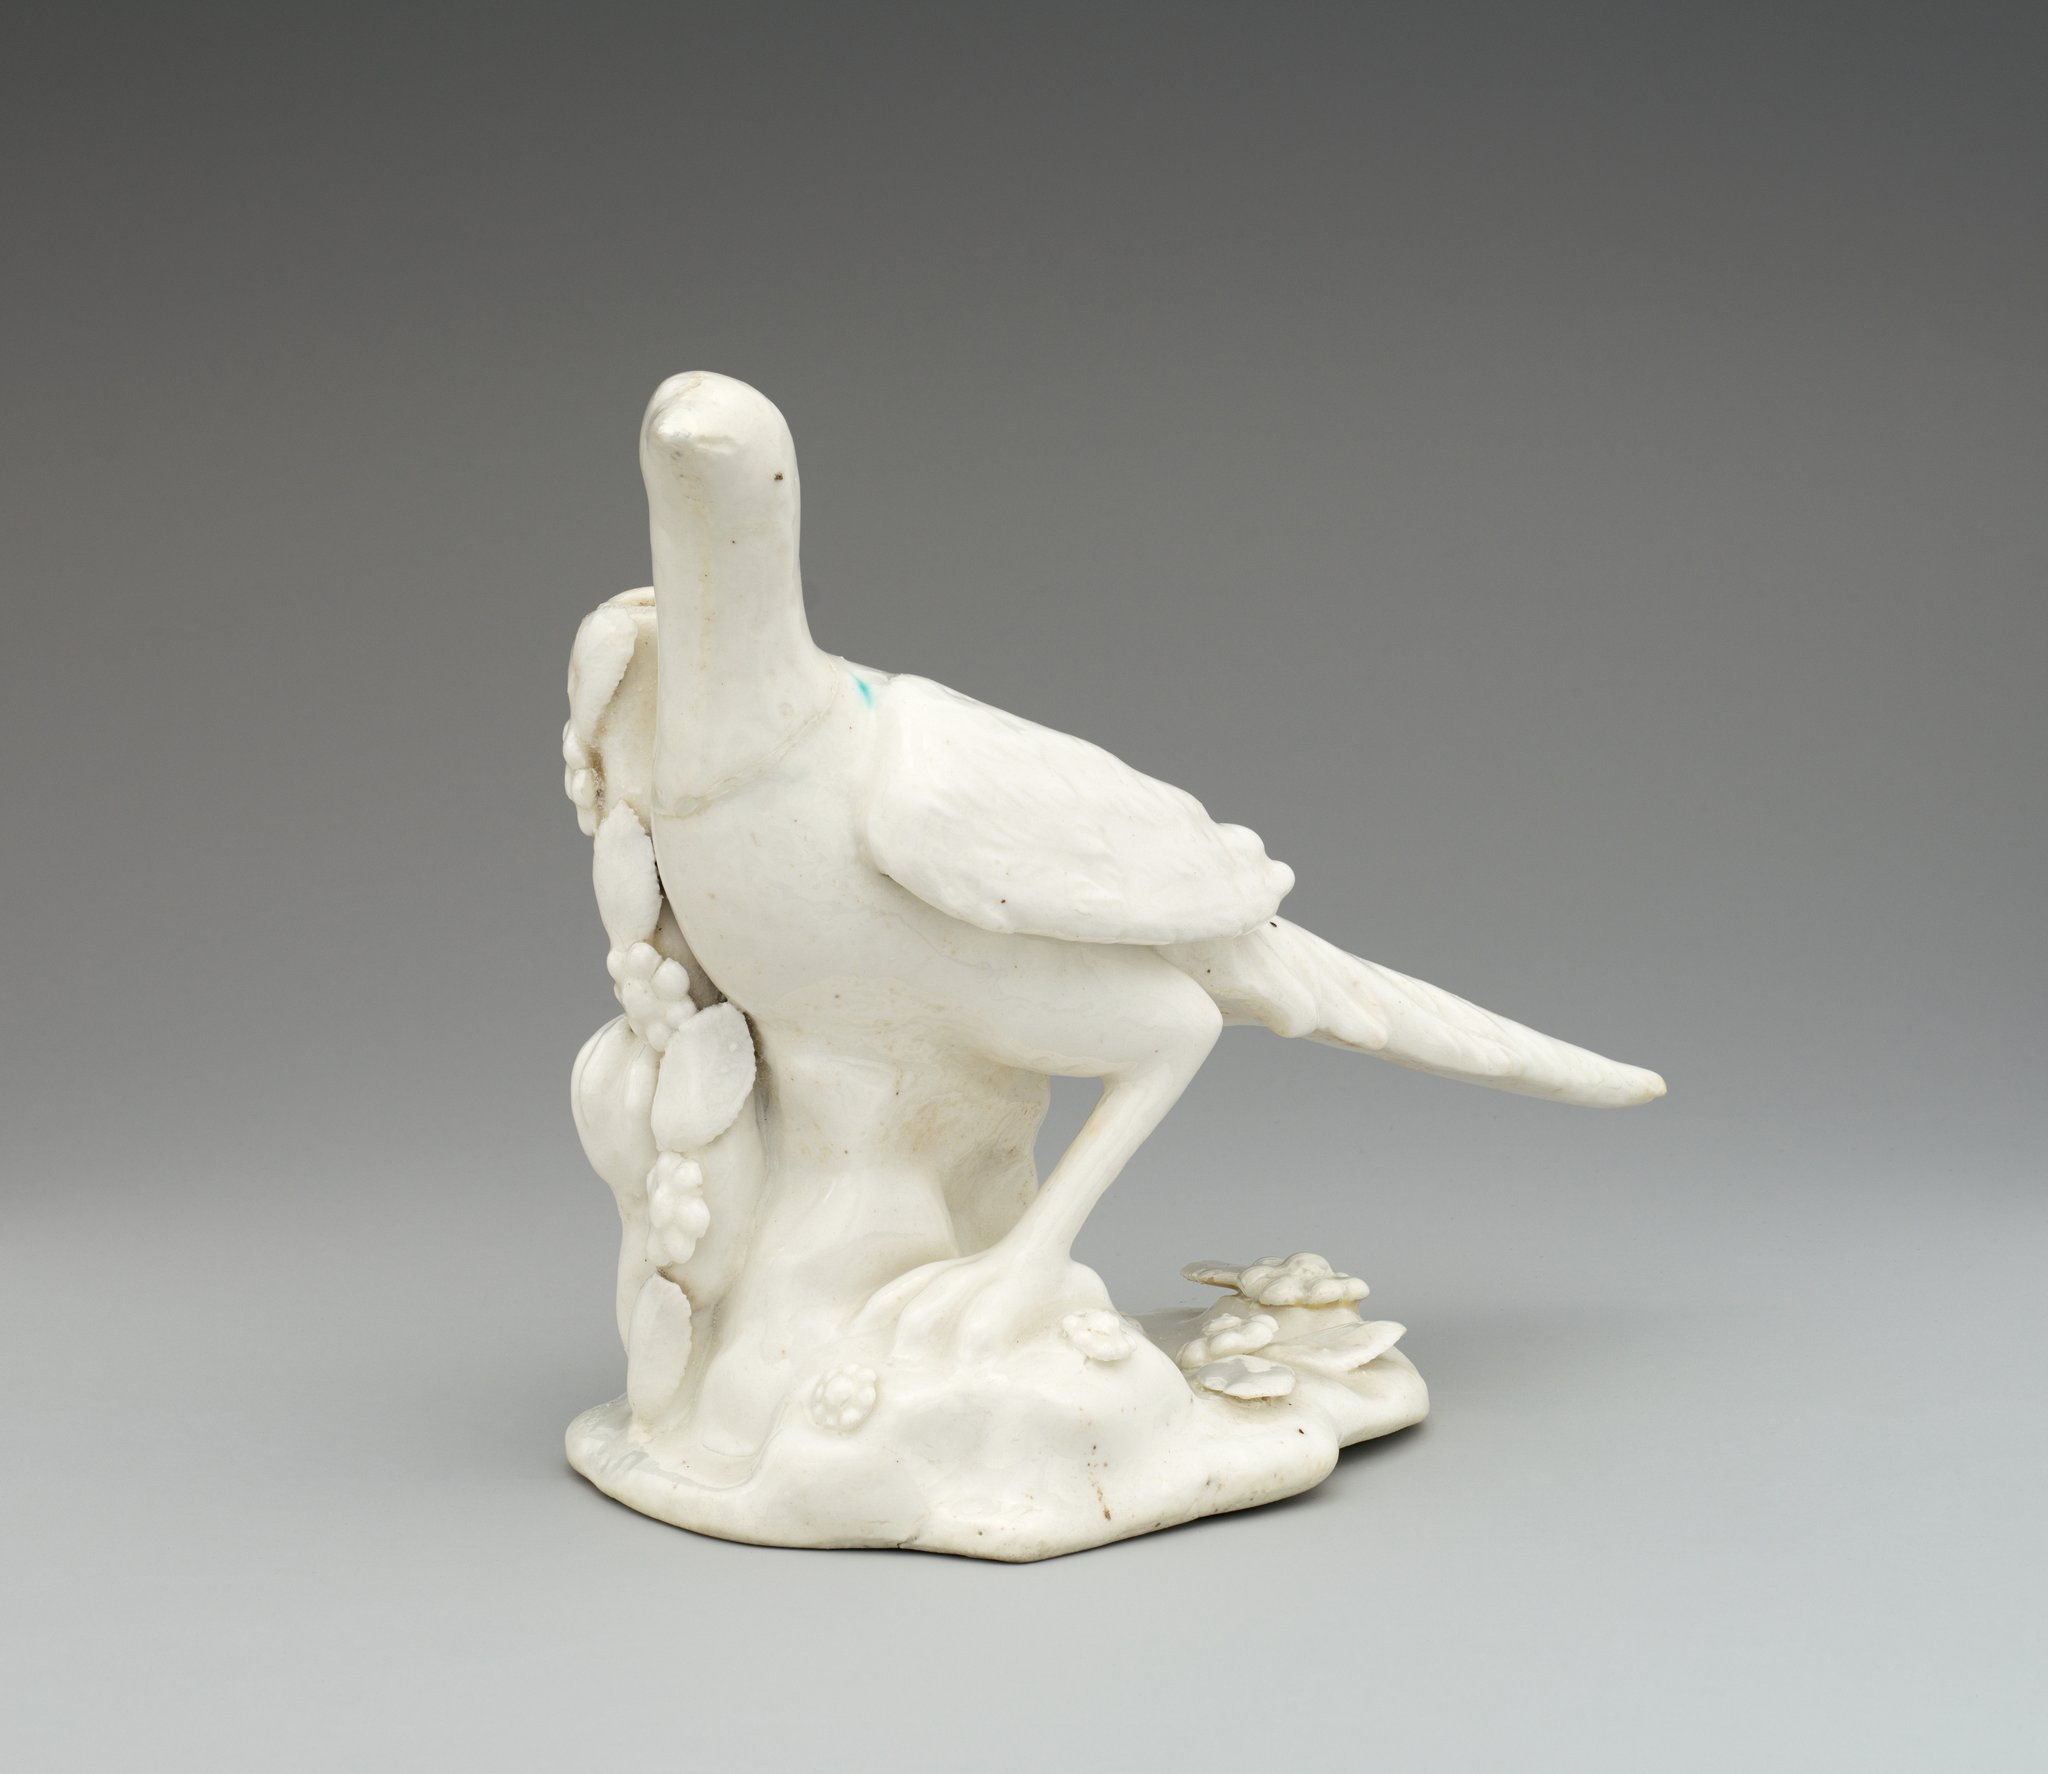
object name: figure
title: Pheasant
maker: william littler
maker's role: maker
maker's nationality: british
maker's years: 1729-1784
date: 1750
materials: soft paste porcelain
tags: pheasants